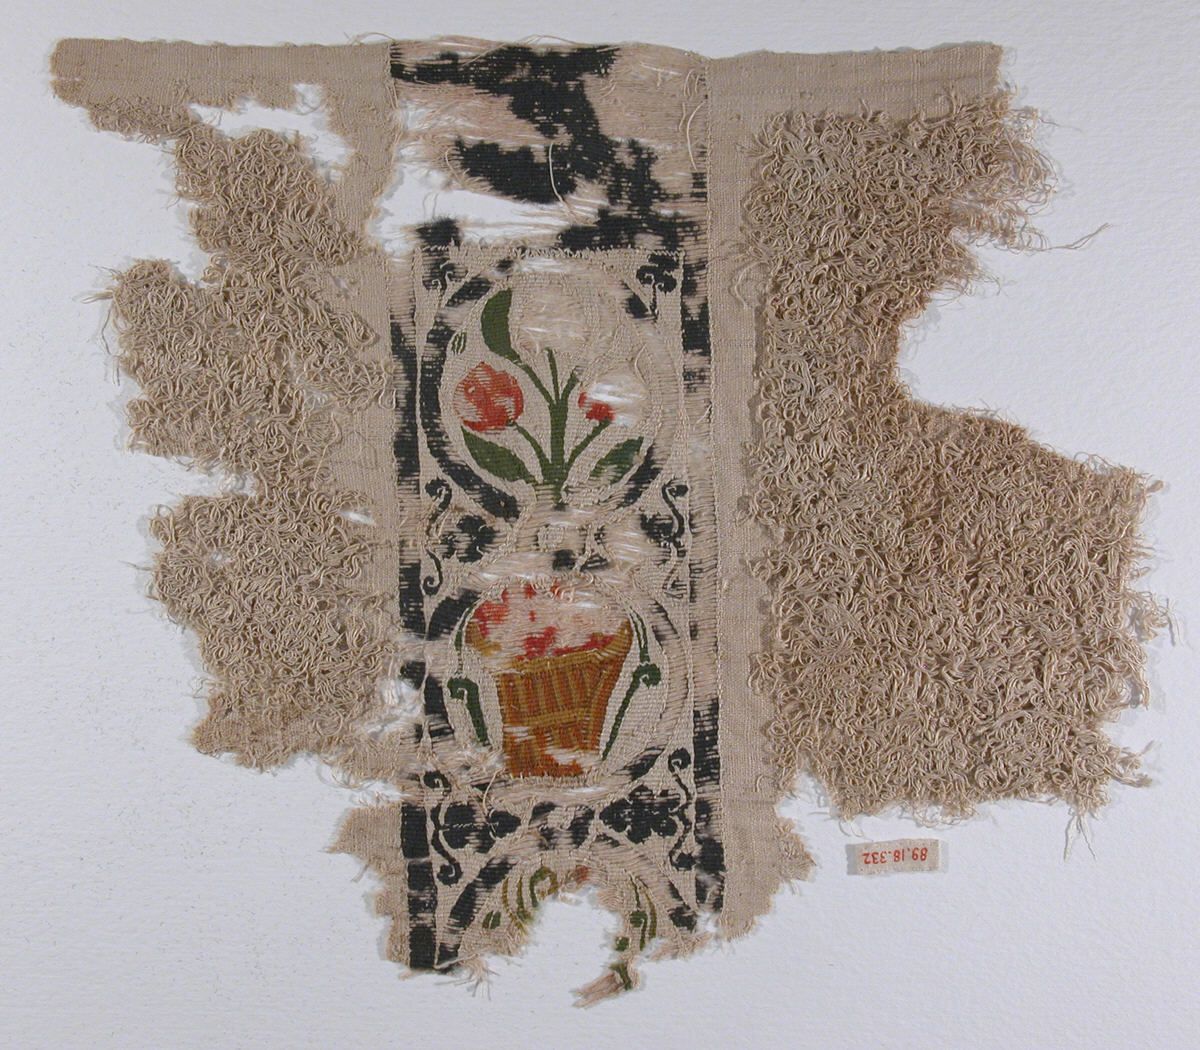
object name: textile fragment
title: Fragment with a Band of Baskets and Plants and a Loop Pile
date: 301-600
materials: linen, wool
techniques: weave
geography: egypt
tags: flowers